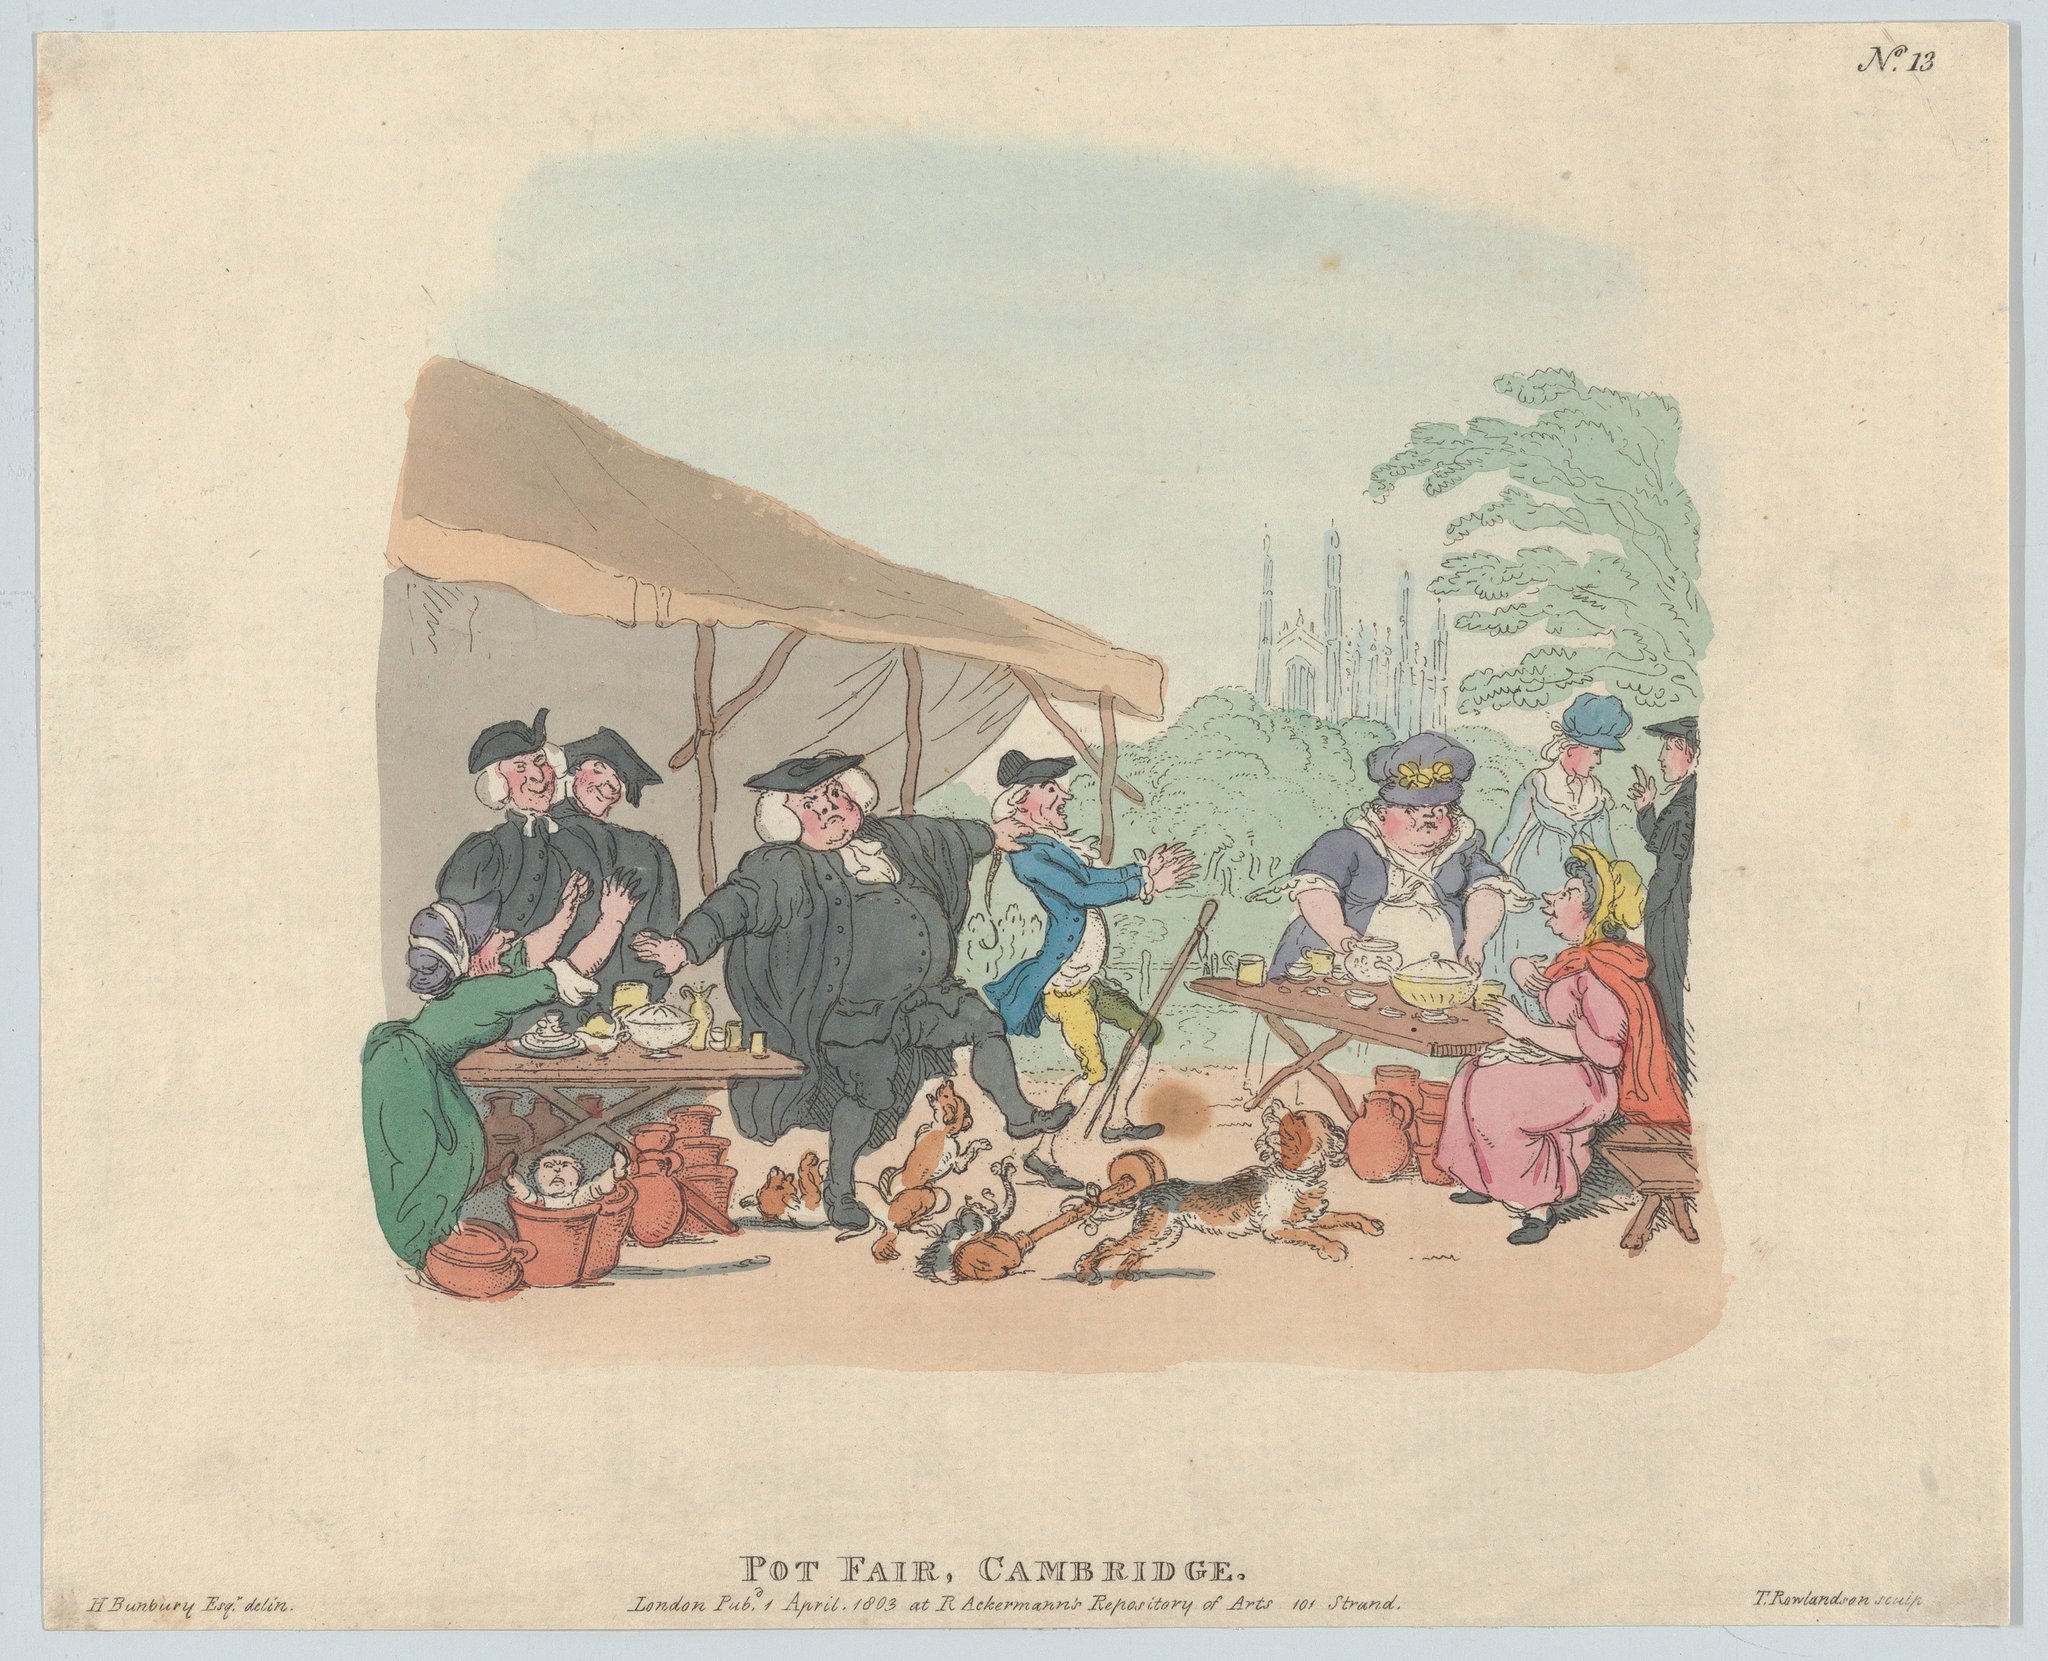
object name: print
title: Pot Fair Cambridge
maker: thomas rowlandson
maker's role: artist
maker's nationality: british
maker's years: 1757-1827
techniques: etching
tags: satire,men,women,dogs